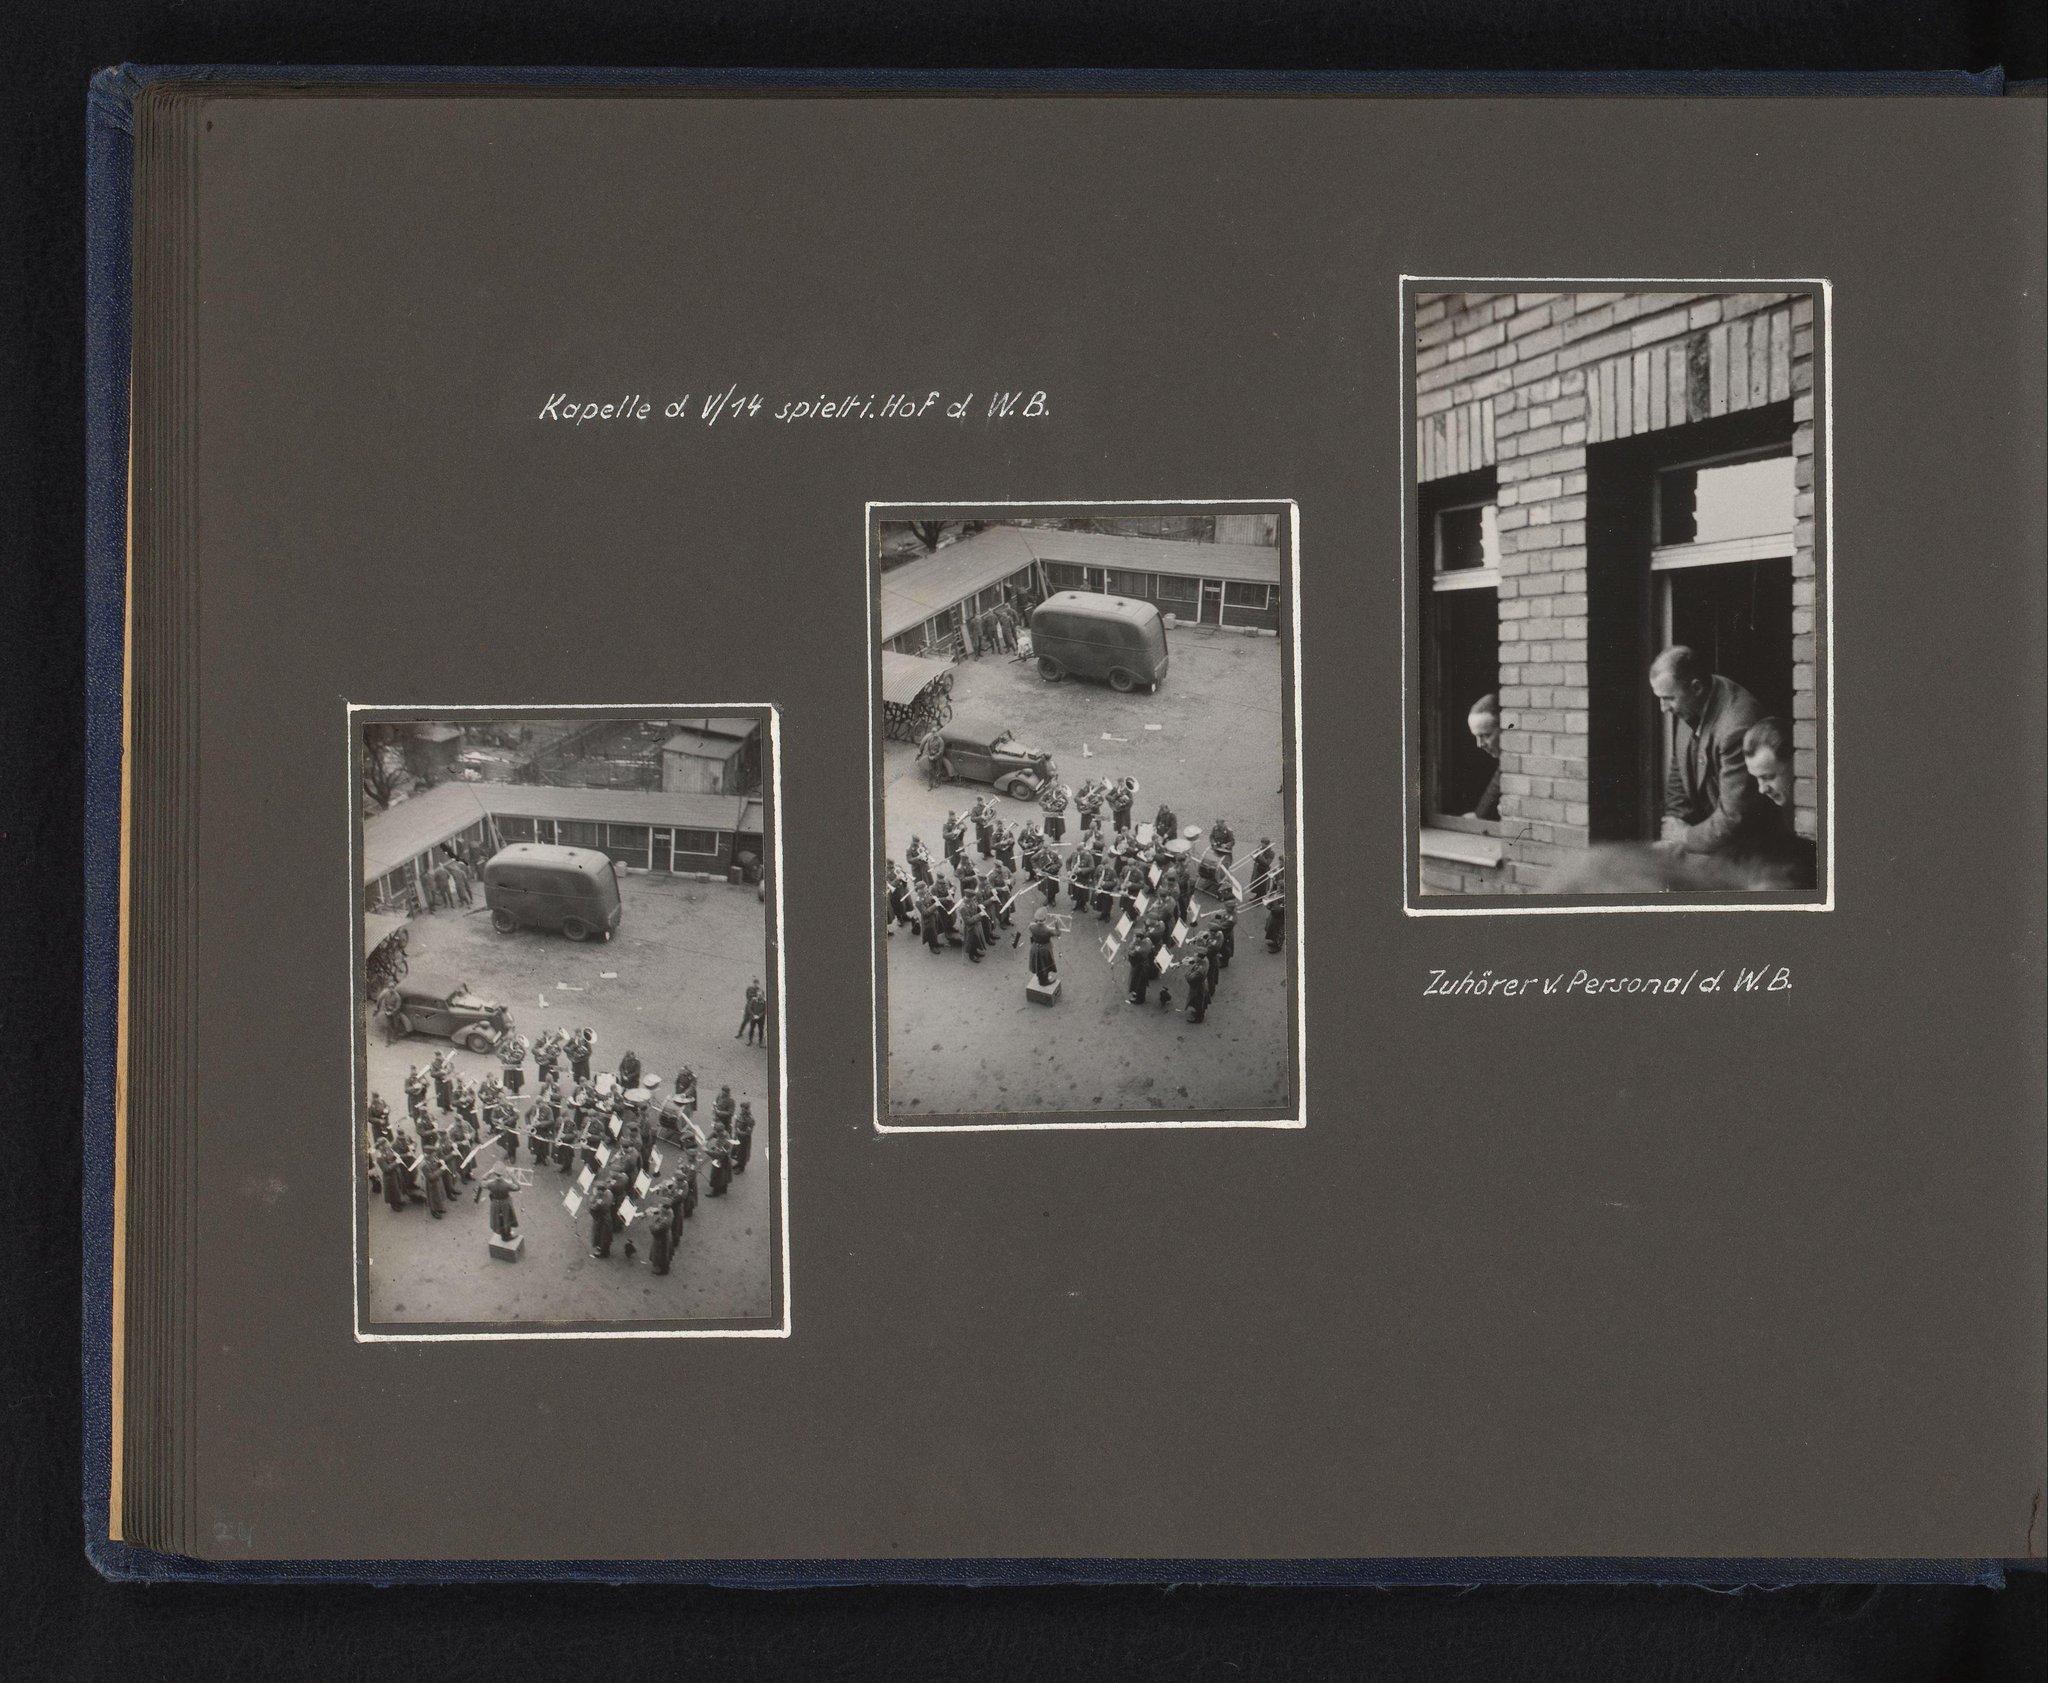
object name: album leaf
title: MIlitaire kapel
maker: Anonymous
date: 1939-1940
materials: paper, photographic support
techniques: gelatin silver print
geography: germany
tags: military band, germany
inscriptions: inscription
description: Albumblad met drie foto's van een militaire kapel die muziek speelt op een binnenplaatsvan het gebouw van de Westdeutscher Beobachter, winter 1939-1940. Onderdeel van een Duits militair album Tweede Wereldoorlog 1939-1940.